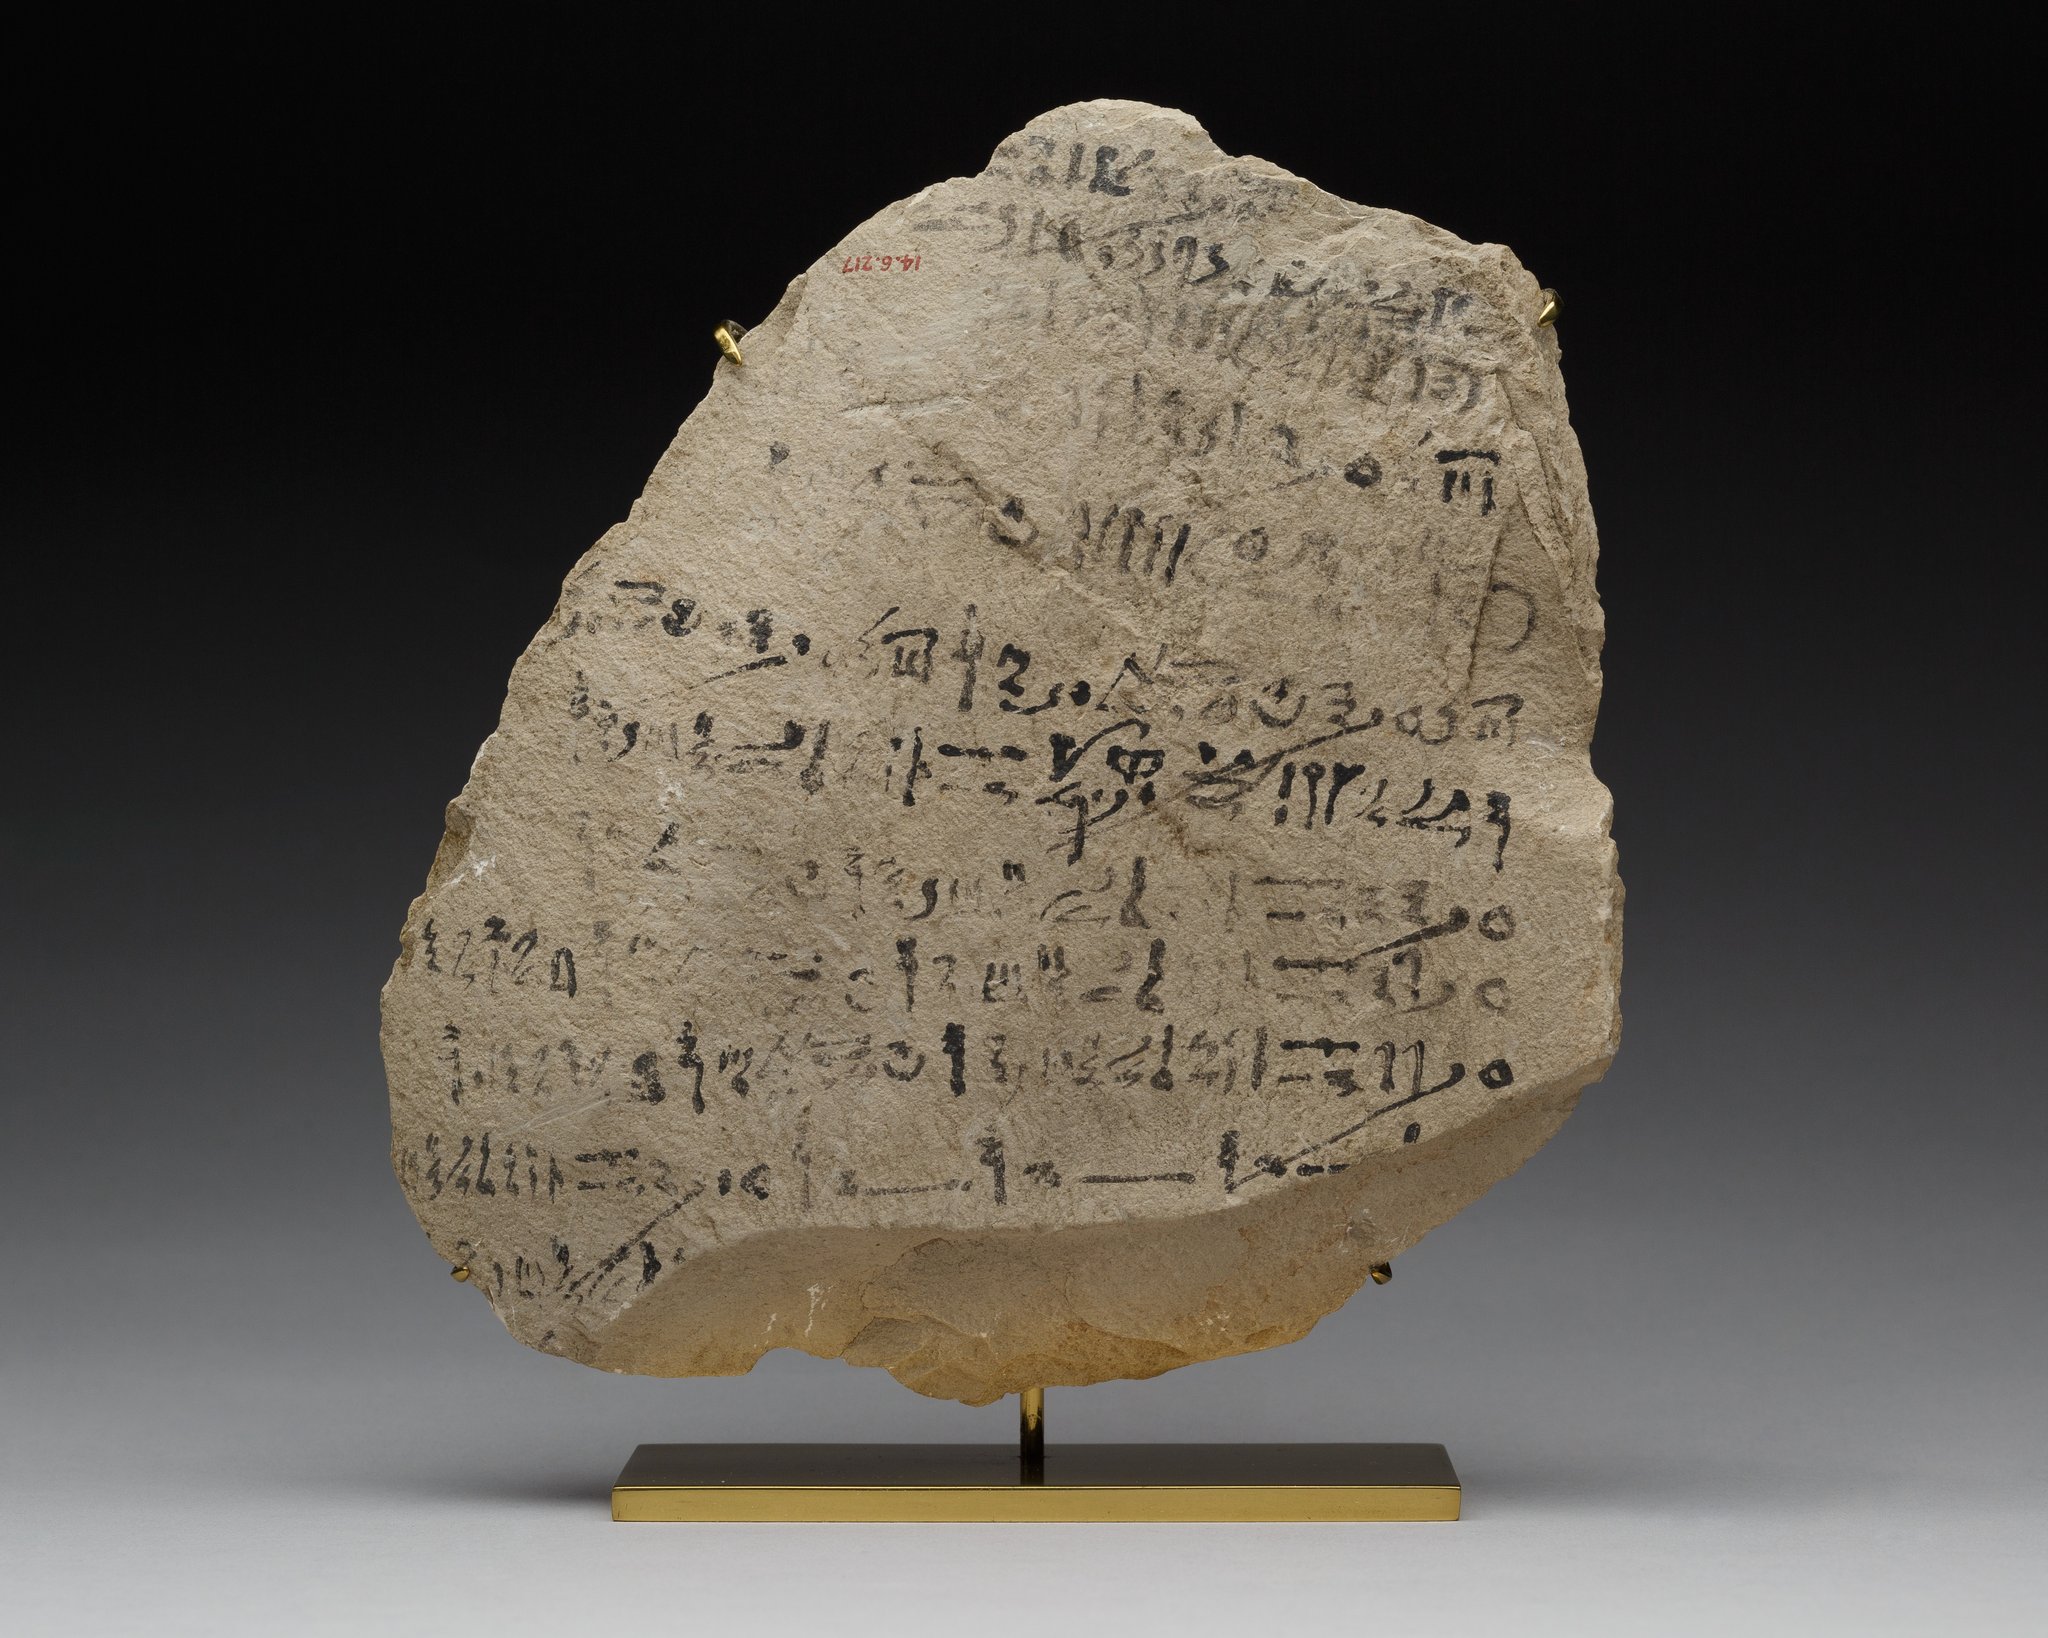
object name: ostracon, hieratic, seti ii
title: Hieratic ostracon recording the accession of Seti II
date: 1200-1194 BCE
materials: limestone, paint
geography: egypt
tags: hieratic